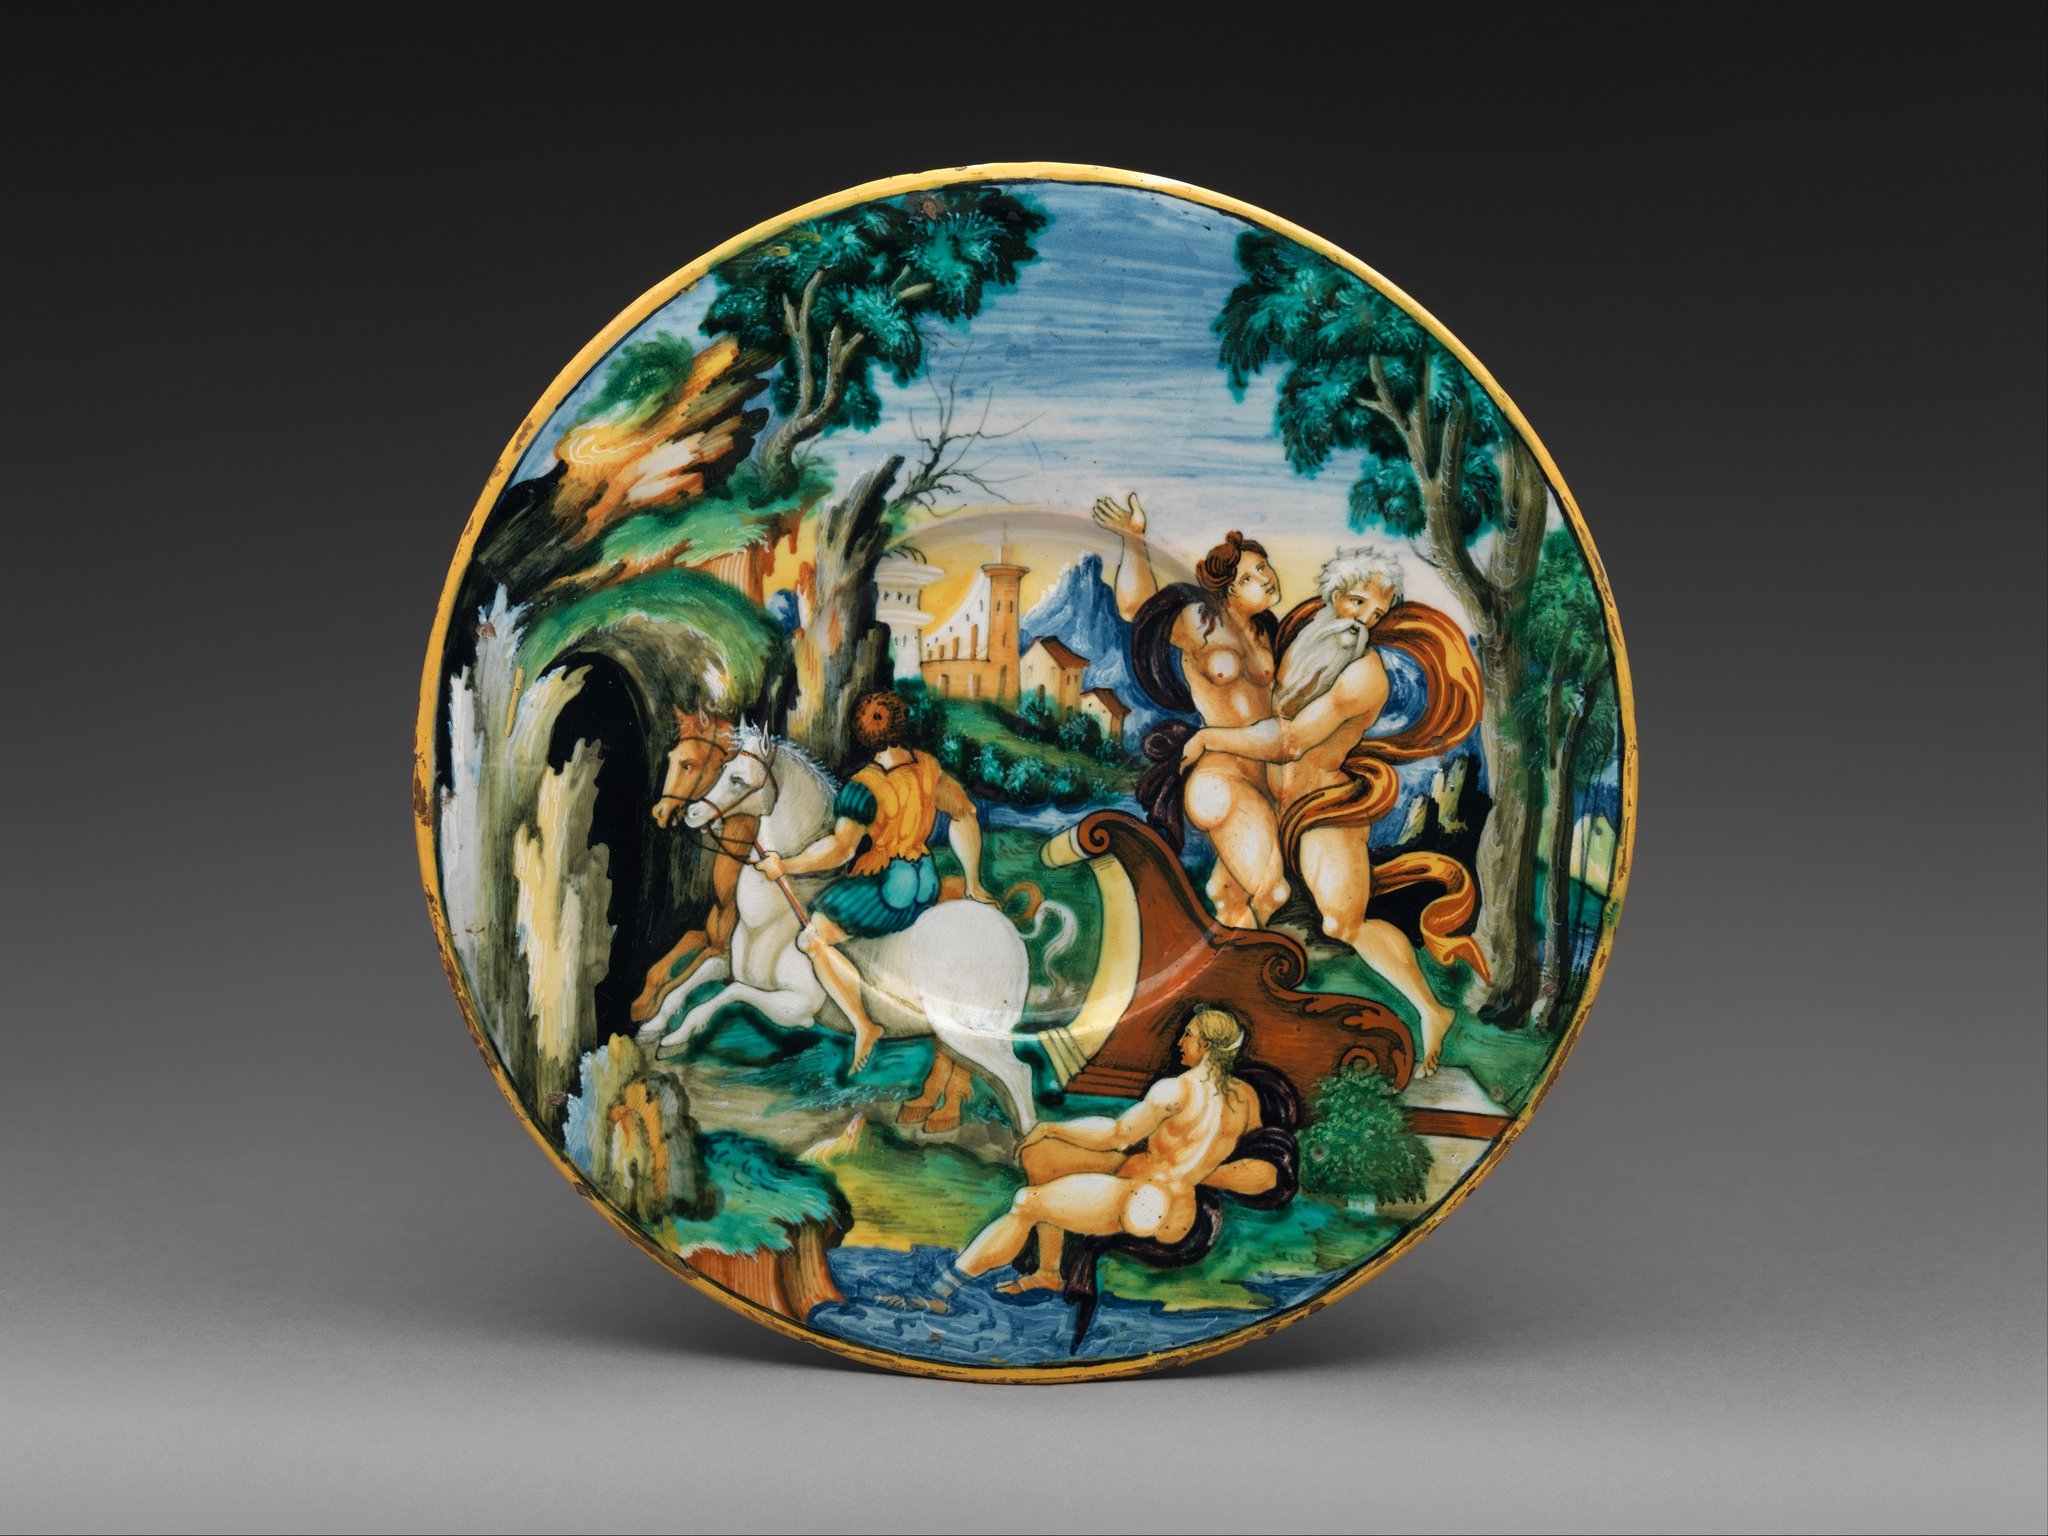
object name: plate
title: Plate with The Rape of Prosperina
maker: the "milan marsyas" painter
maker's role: artist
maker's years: 1500-1550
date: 1530-1535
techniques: maiolica, glazing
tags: male nudes,female nudes,horses